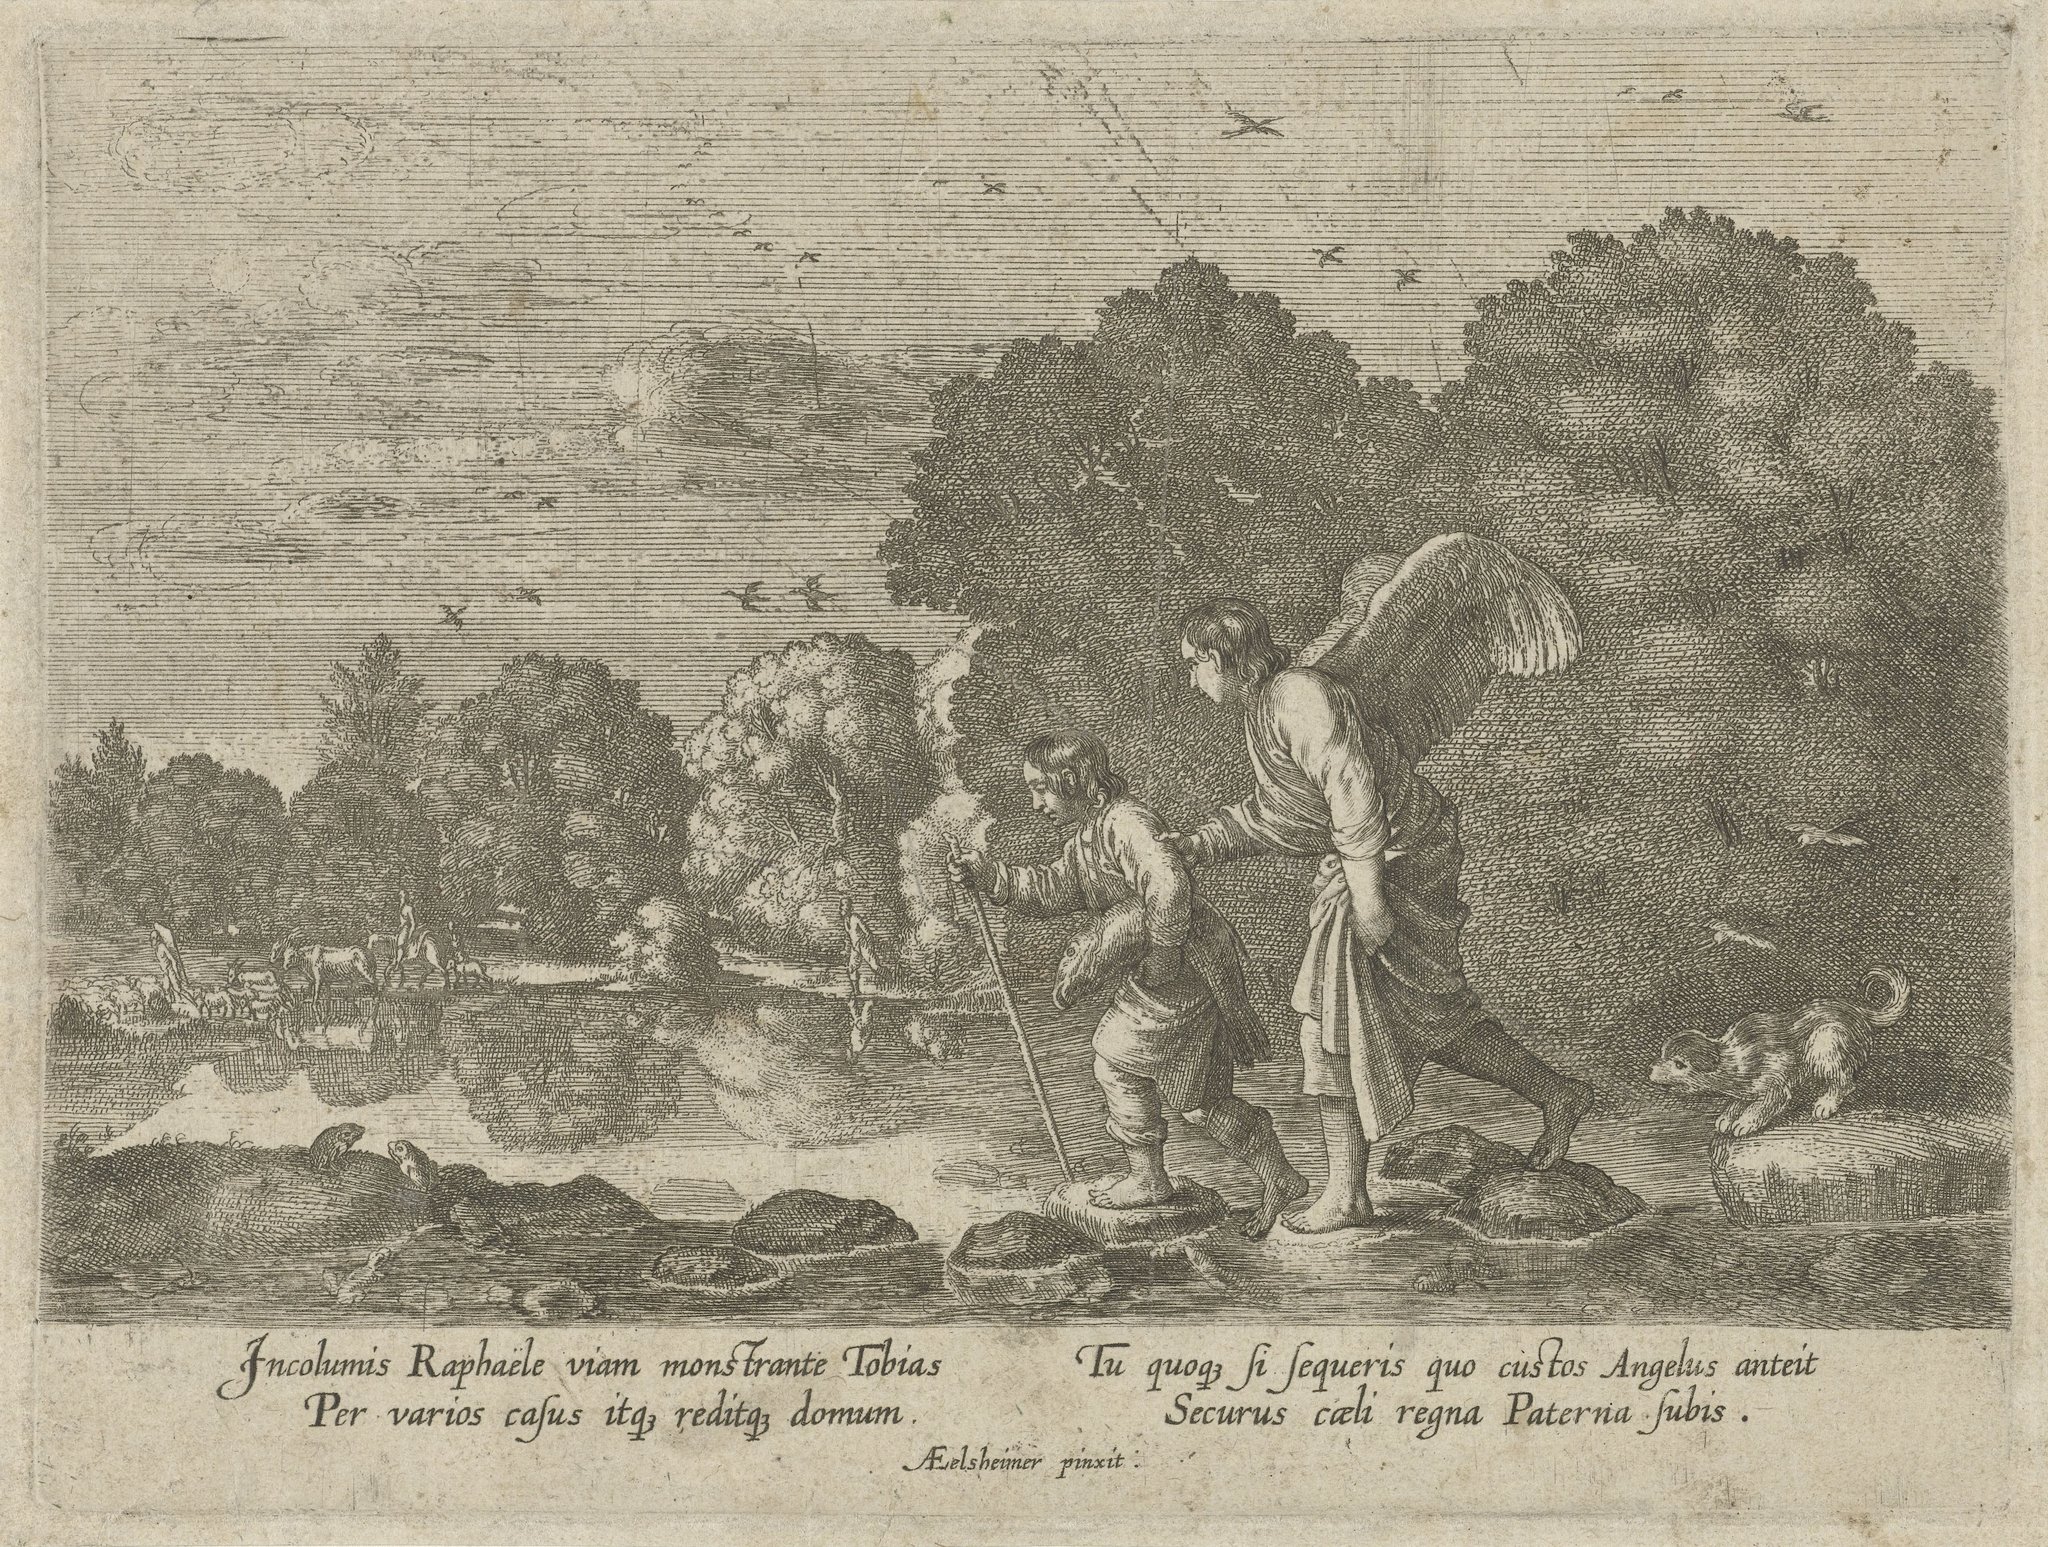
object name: print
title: Tobias en de engel bij een rivier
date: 1608-1698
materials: paper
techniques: engraving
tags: tobias and the angel raphael travelling, accompanied by tobias' dog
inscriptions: collector's mark: Lugt 2228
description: Tobias en de engel Rafaël steken een rivier over. Een hond volgt hen. In Tobias' handen een grote vis. Tobias zal de vis zijn gal later gebruiken om zijn vaders blindheid te genezen. Op de achtergrond een herder en zijn kudde. De prent heeft een Latijns onderschrift. Naar een schilderij van Adam Elsheimer